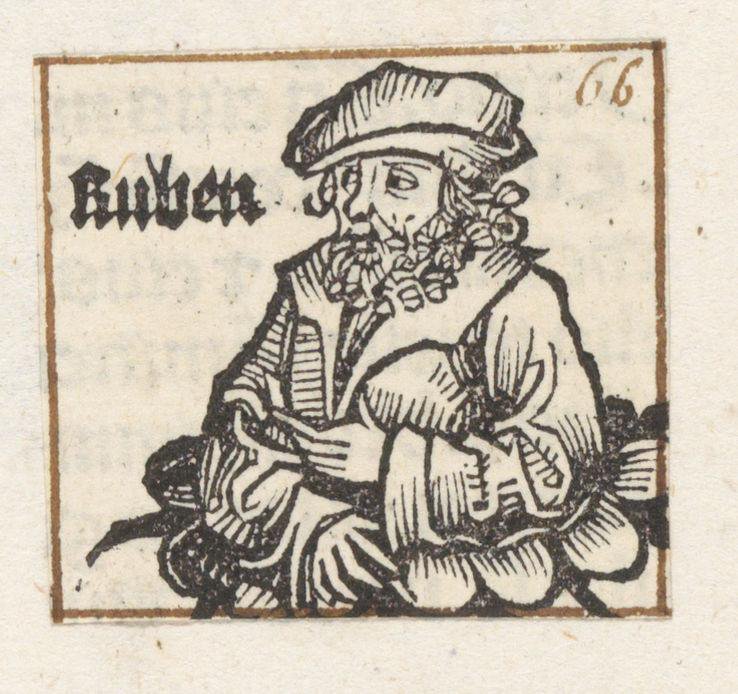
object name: print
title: Liber Chronicarum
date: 1493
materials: paper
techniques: letterpress printing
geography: nuremberg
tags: persons from the old testament (not in biblical context, nor occurring in legendary/historical extensions included in division 71)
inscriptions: inscription: ‘66’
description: Een bloemkelk met een man, naar links gekeerd. De tekst identificeert hem als Ruben, de oudste zoon van Jakob en Lea. De voorstelling is een fragment van de stamboom van Christus in de Liber Chronicarum. De prent maakt deel uit van een album.